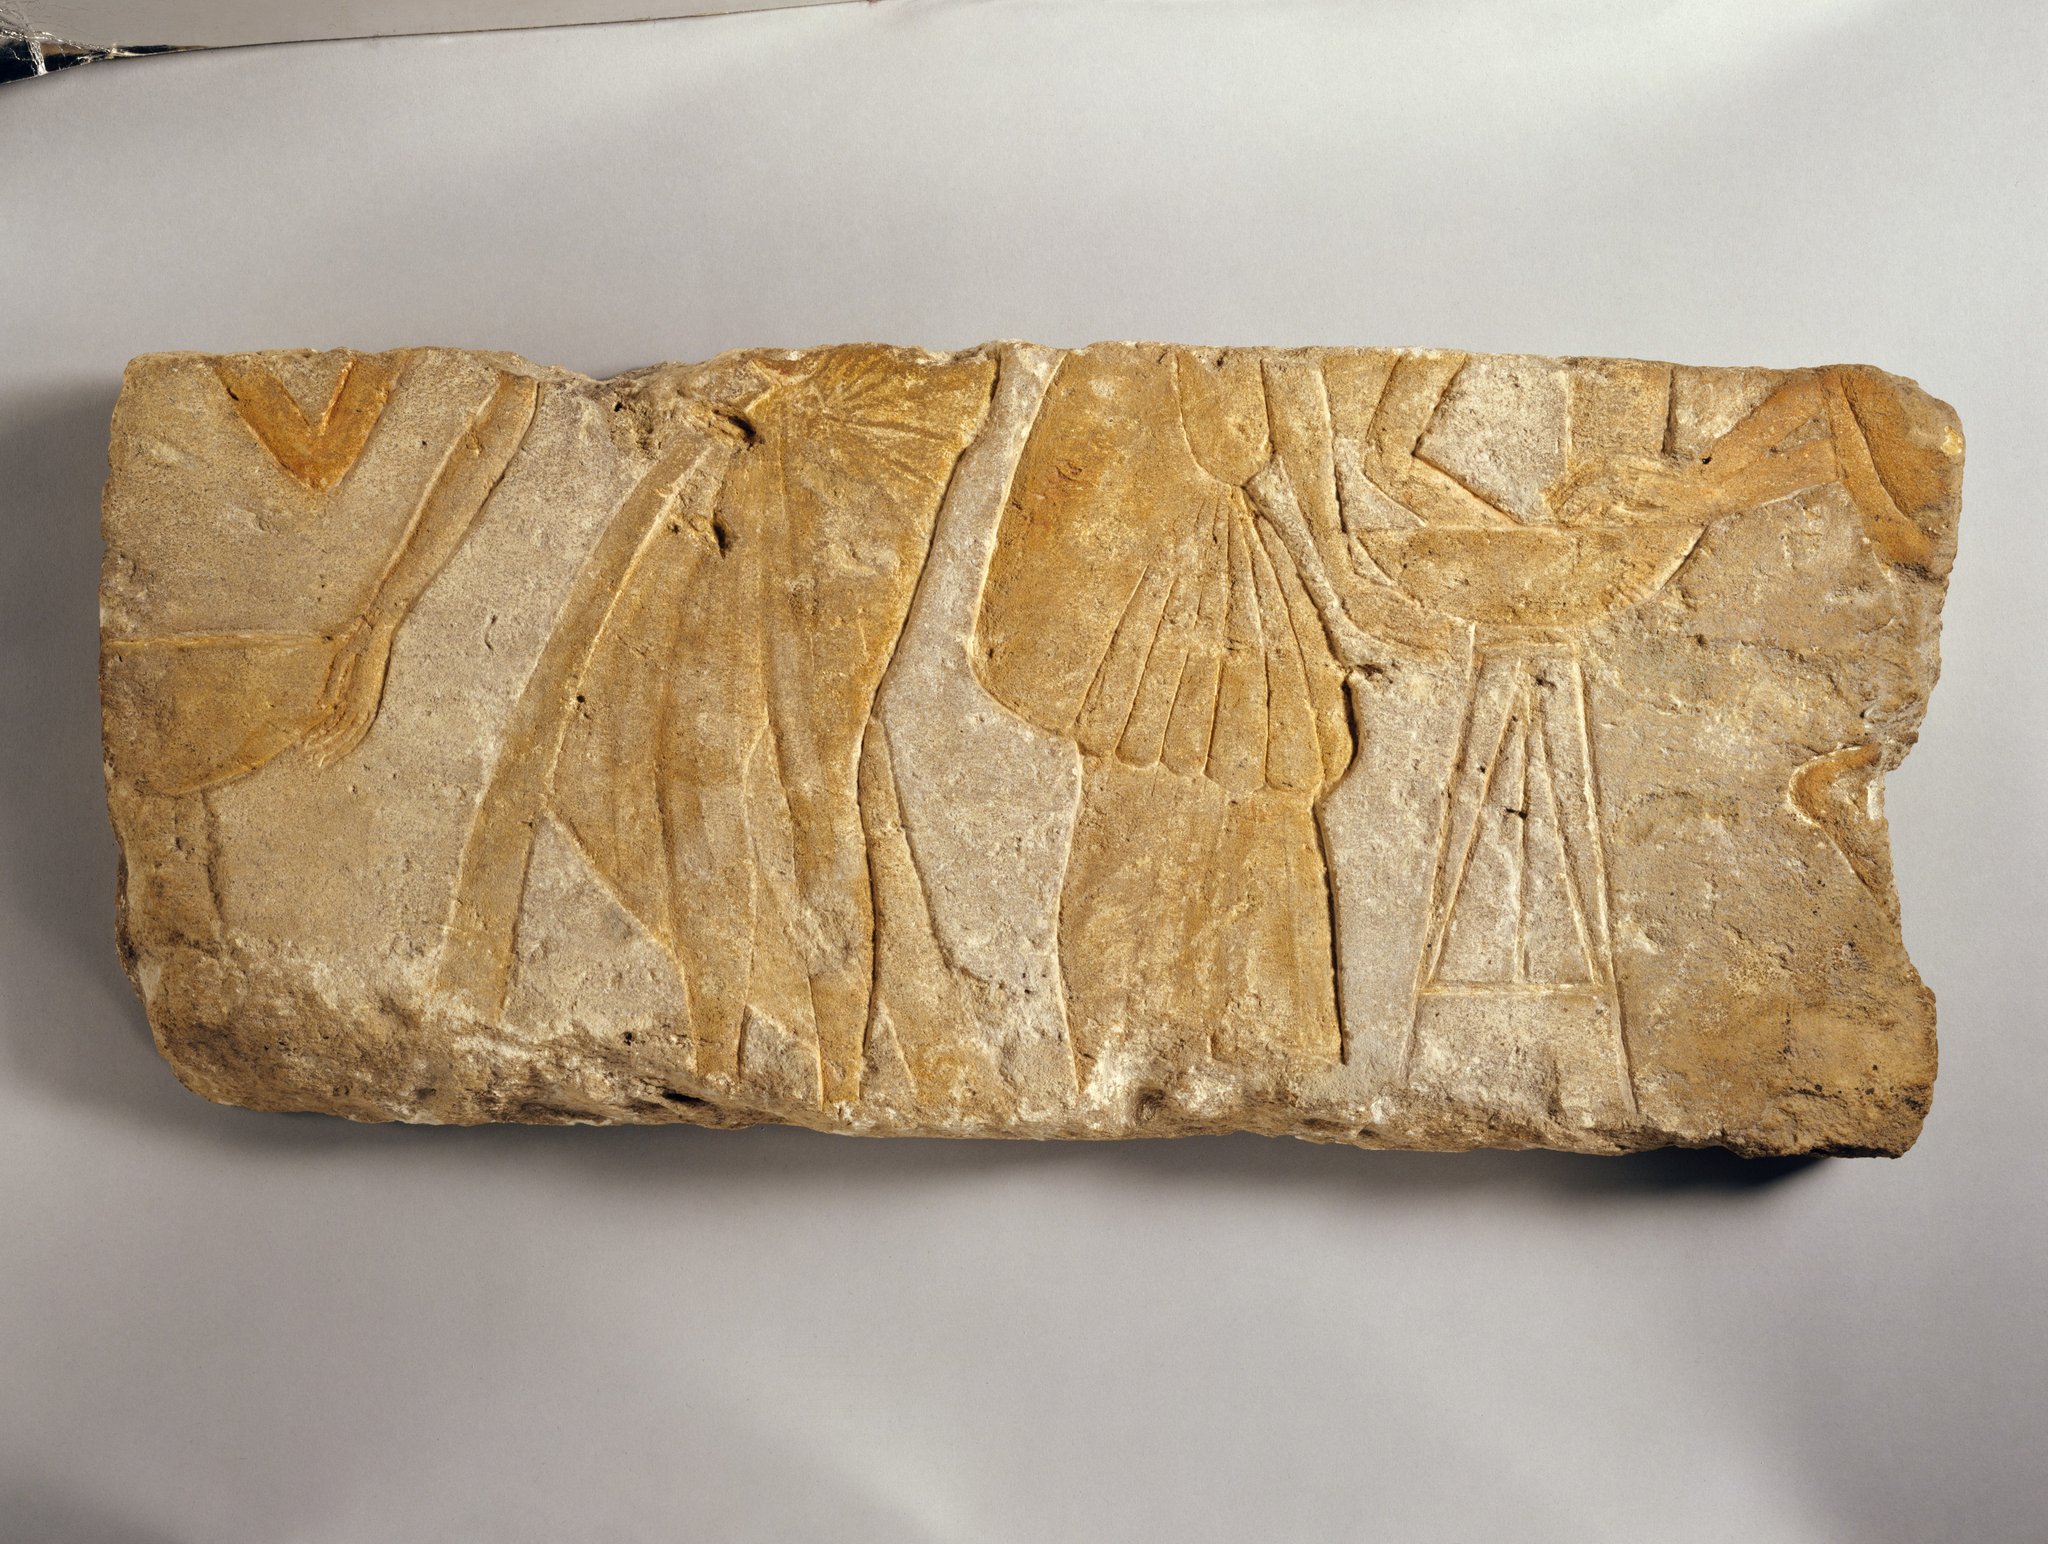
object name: talatat, people setting down brazier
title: Relief with people setting down braziers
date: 1353-1336 BCE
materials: limestone, paint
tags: human figures